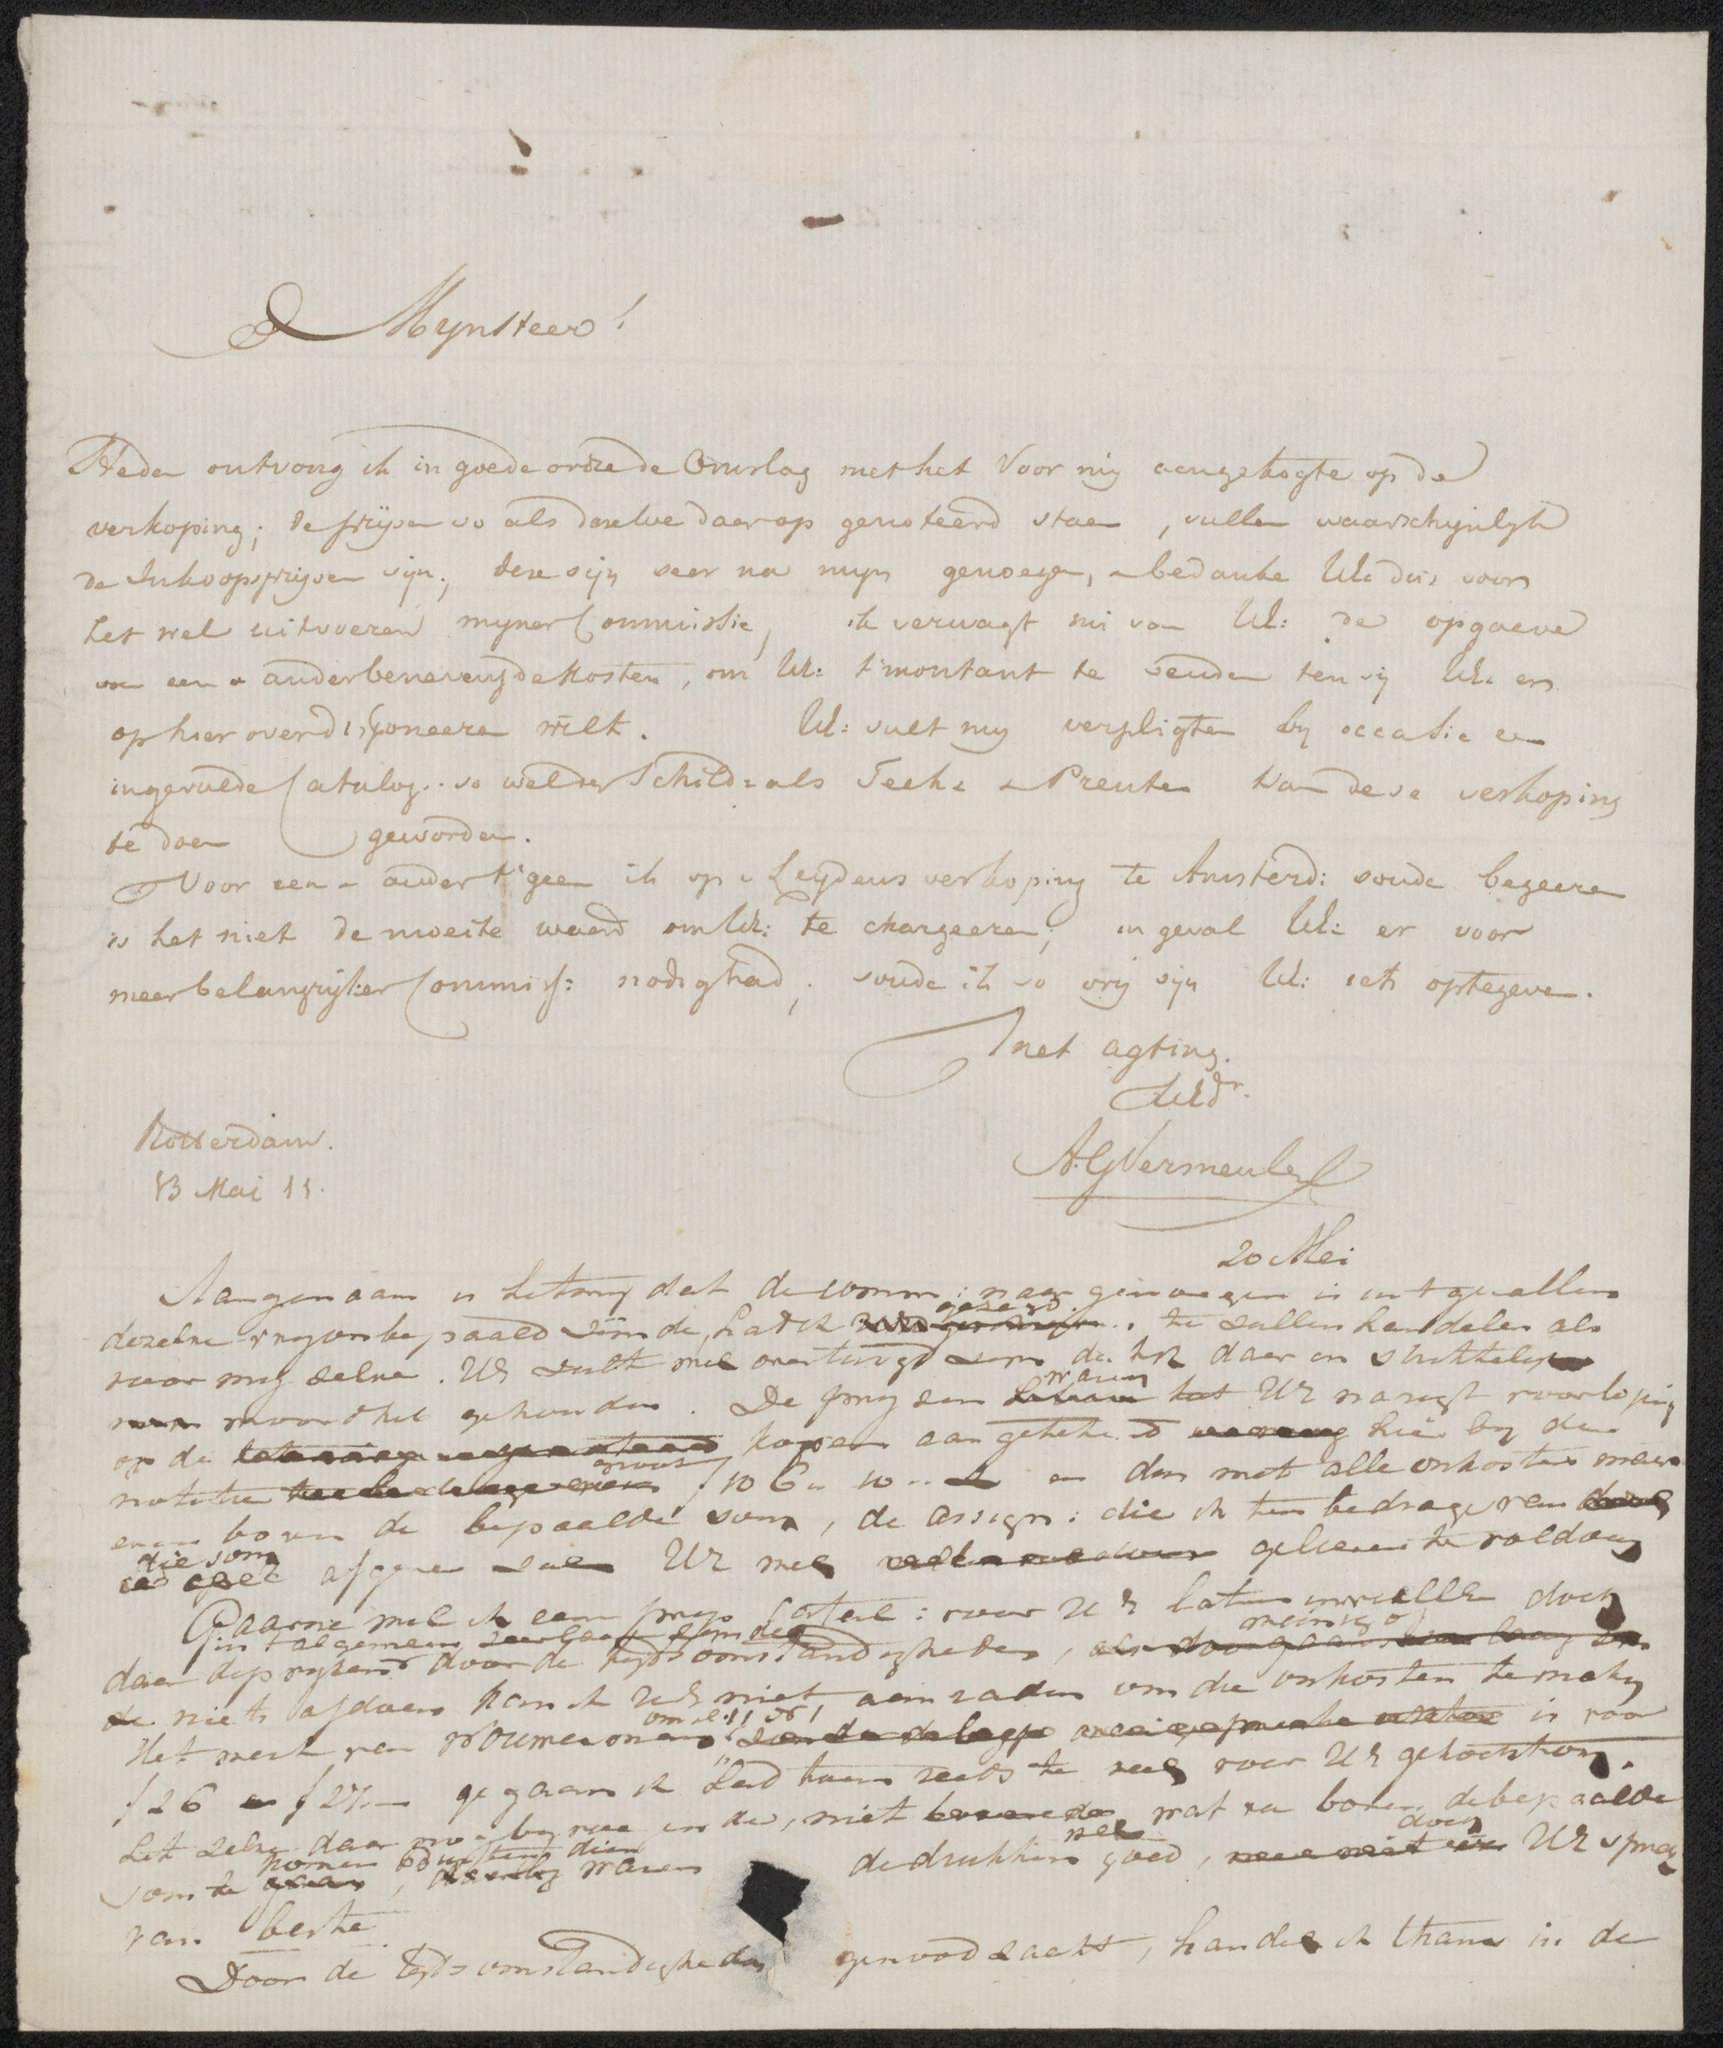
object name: letter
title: Brief aan Adriaan van der Willigen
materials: ink, paper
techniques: pen, writing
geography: rotterdam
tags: haarlem, draughtsman, adriaan van der willigen, art trade, art shop, drawing, the graphic arts, painting (including book-illumination, miniature-painting), money, leiden, amsterdam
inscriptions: stamp: ‘ROTTERDAM’, collector's mark: ‘RPK’, watermark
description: Brief bevat conceptbrief van Adriaan van der Willigen aan G. Vermeulen. Betreft vermoedelijk de veiling van A. Vermande in Haarlem op 6 mei 1811.